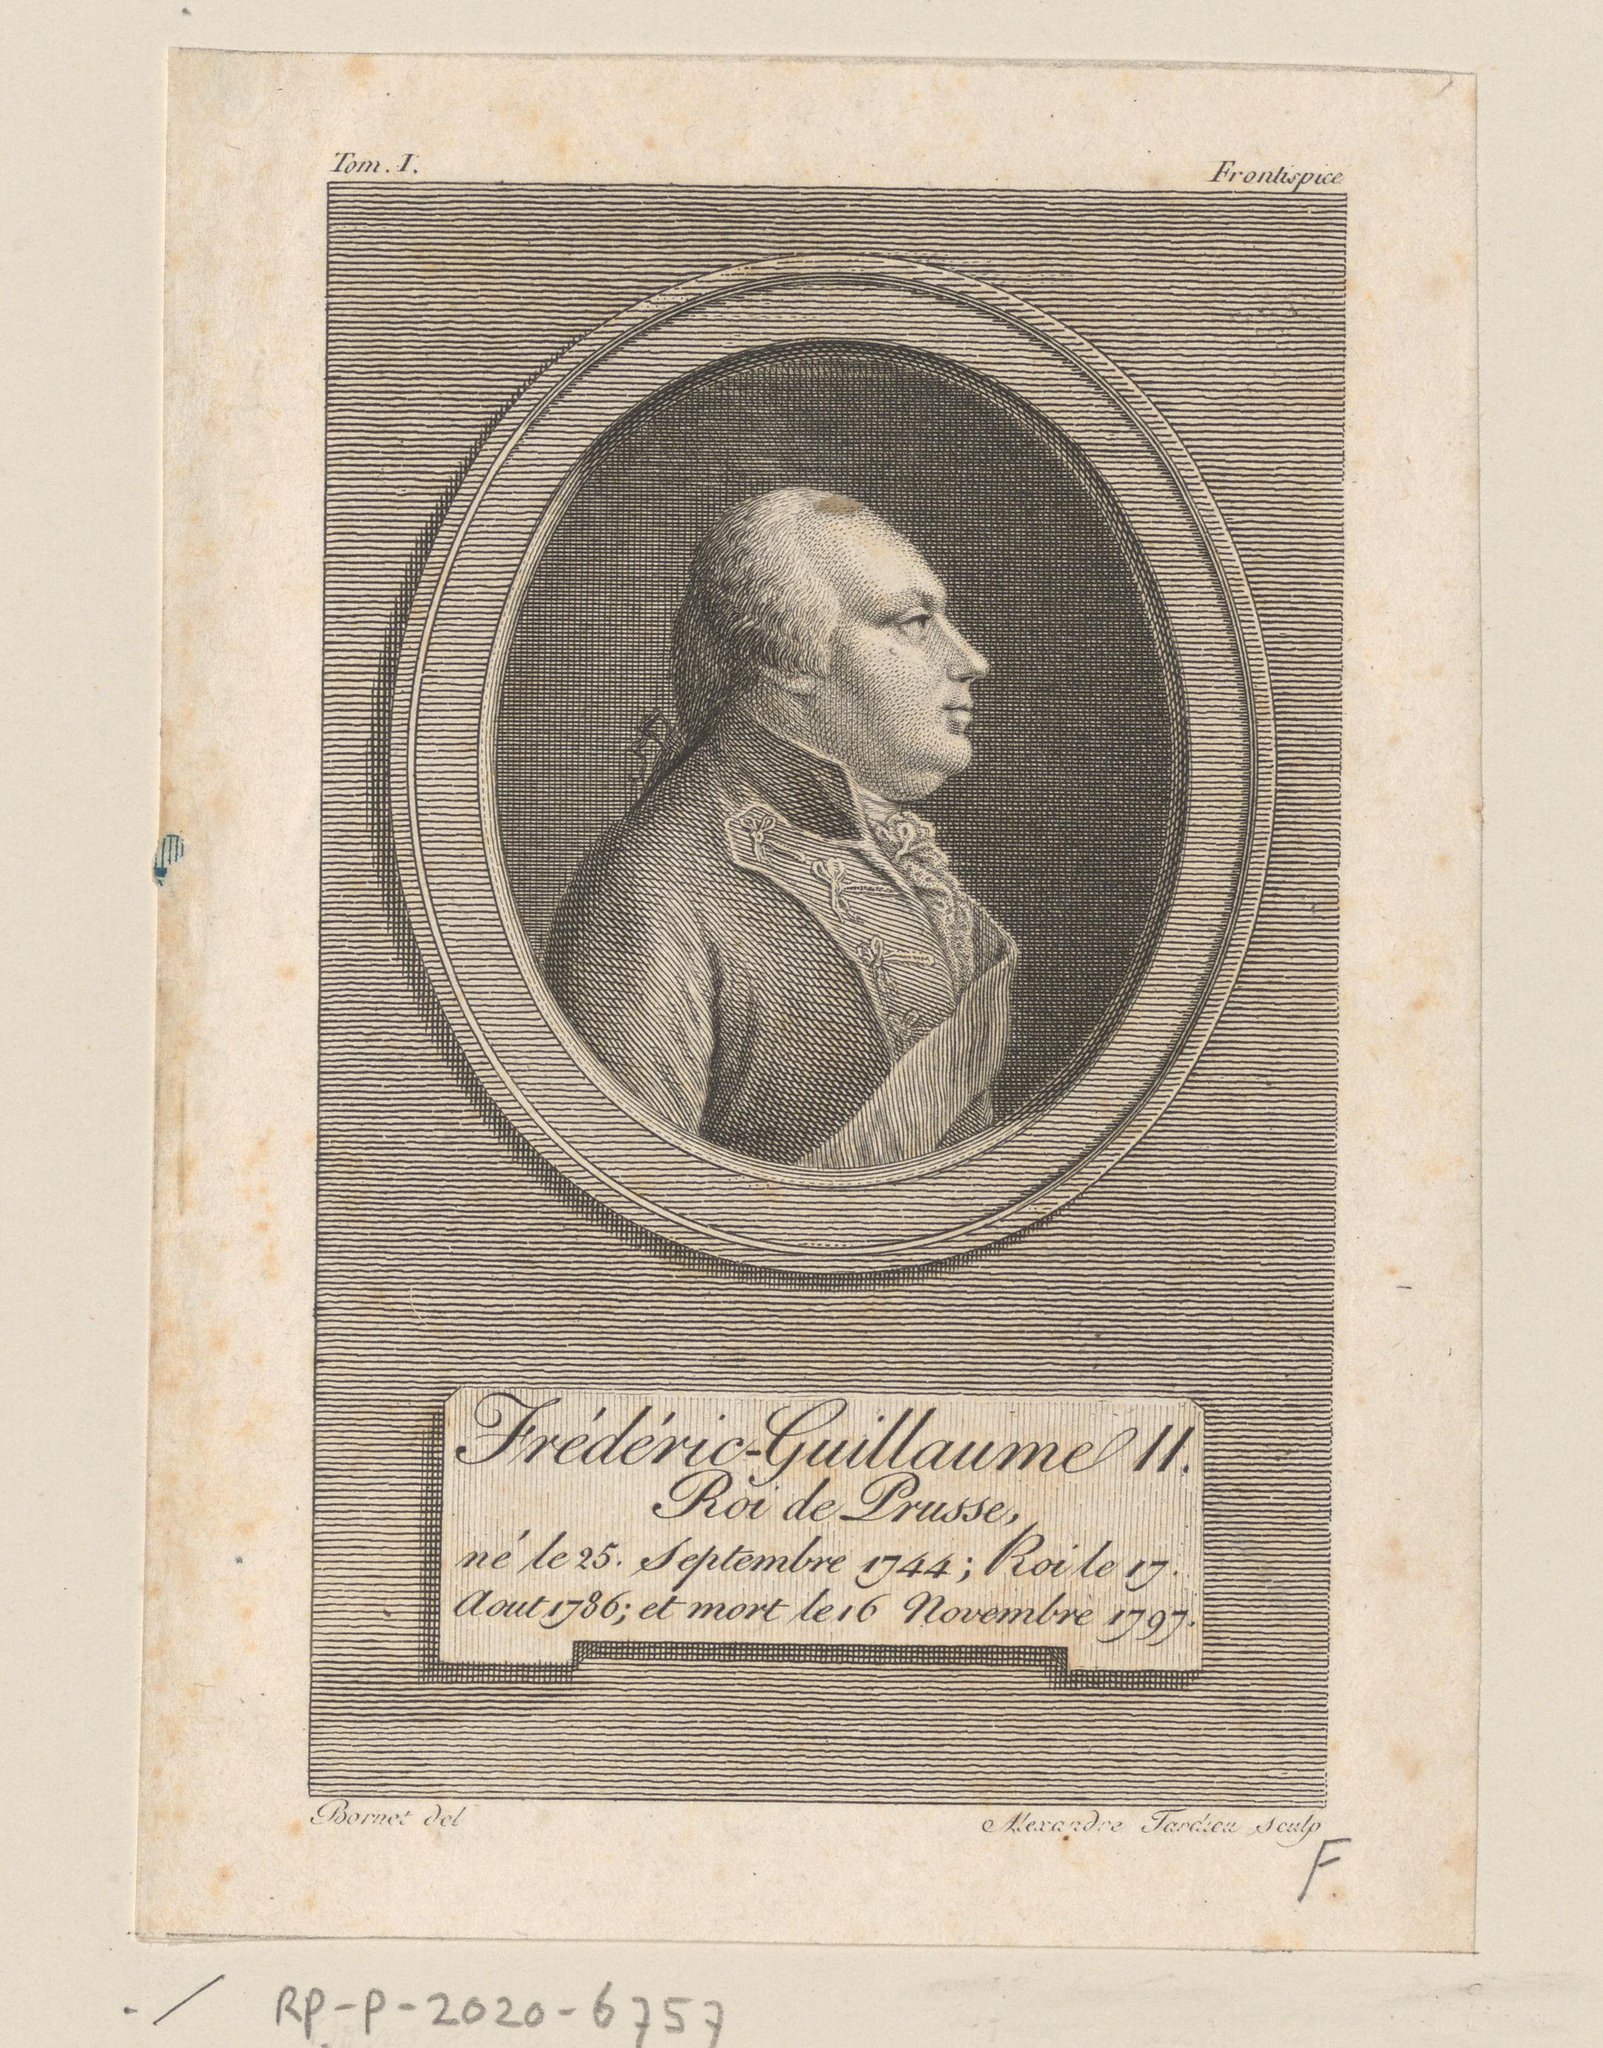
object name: print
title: Portret van Frederik Willem II van Pruisen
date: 1801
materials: paper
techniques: etching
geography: france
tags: berlin, frederik willem ii (koning van pruisen), historical persons, king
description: Prent waarschijnlijk uit: Ségur, Louis Philippe de. Tableau historique et politique de l'Europe (...). Parijs: F. Buisson, 1801, dl. 1.